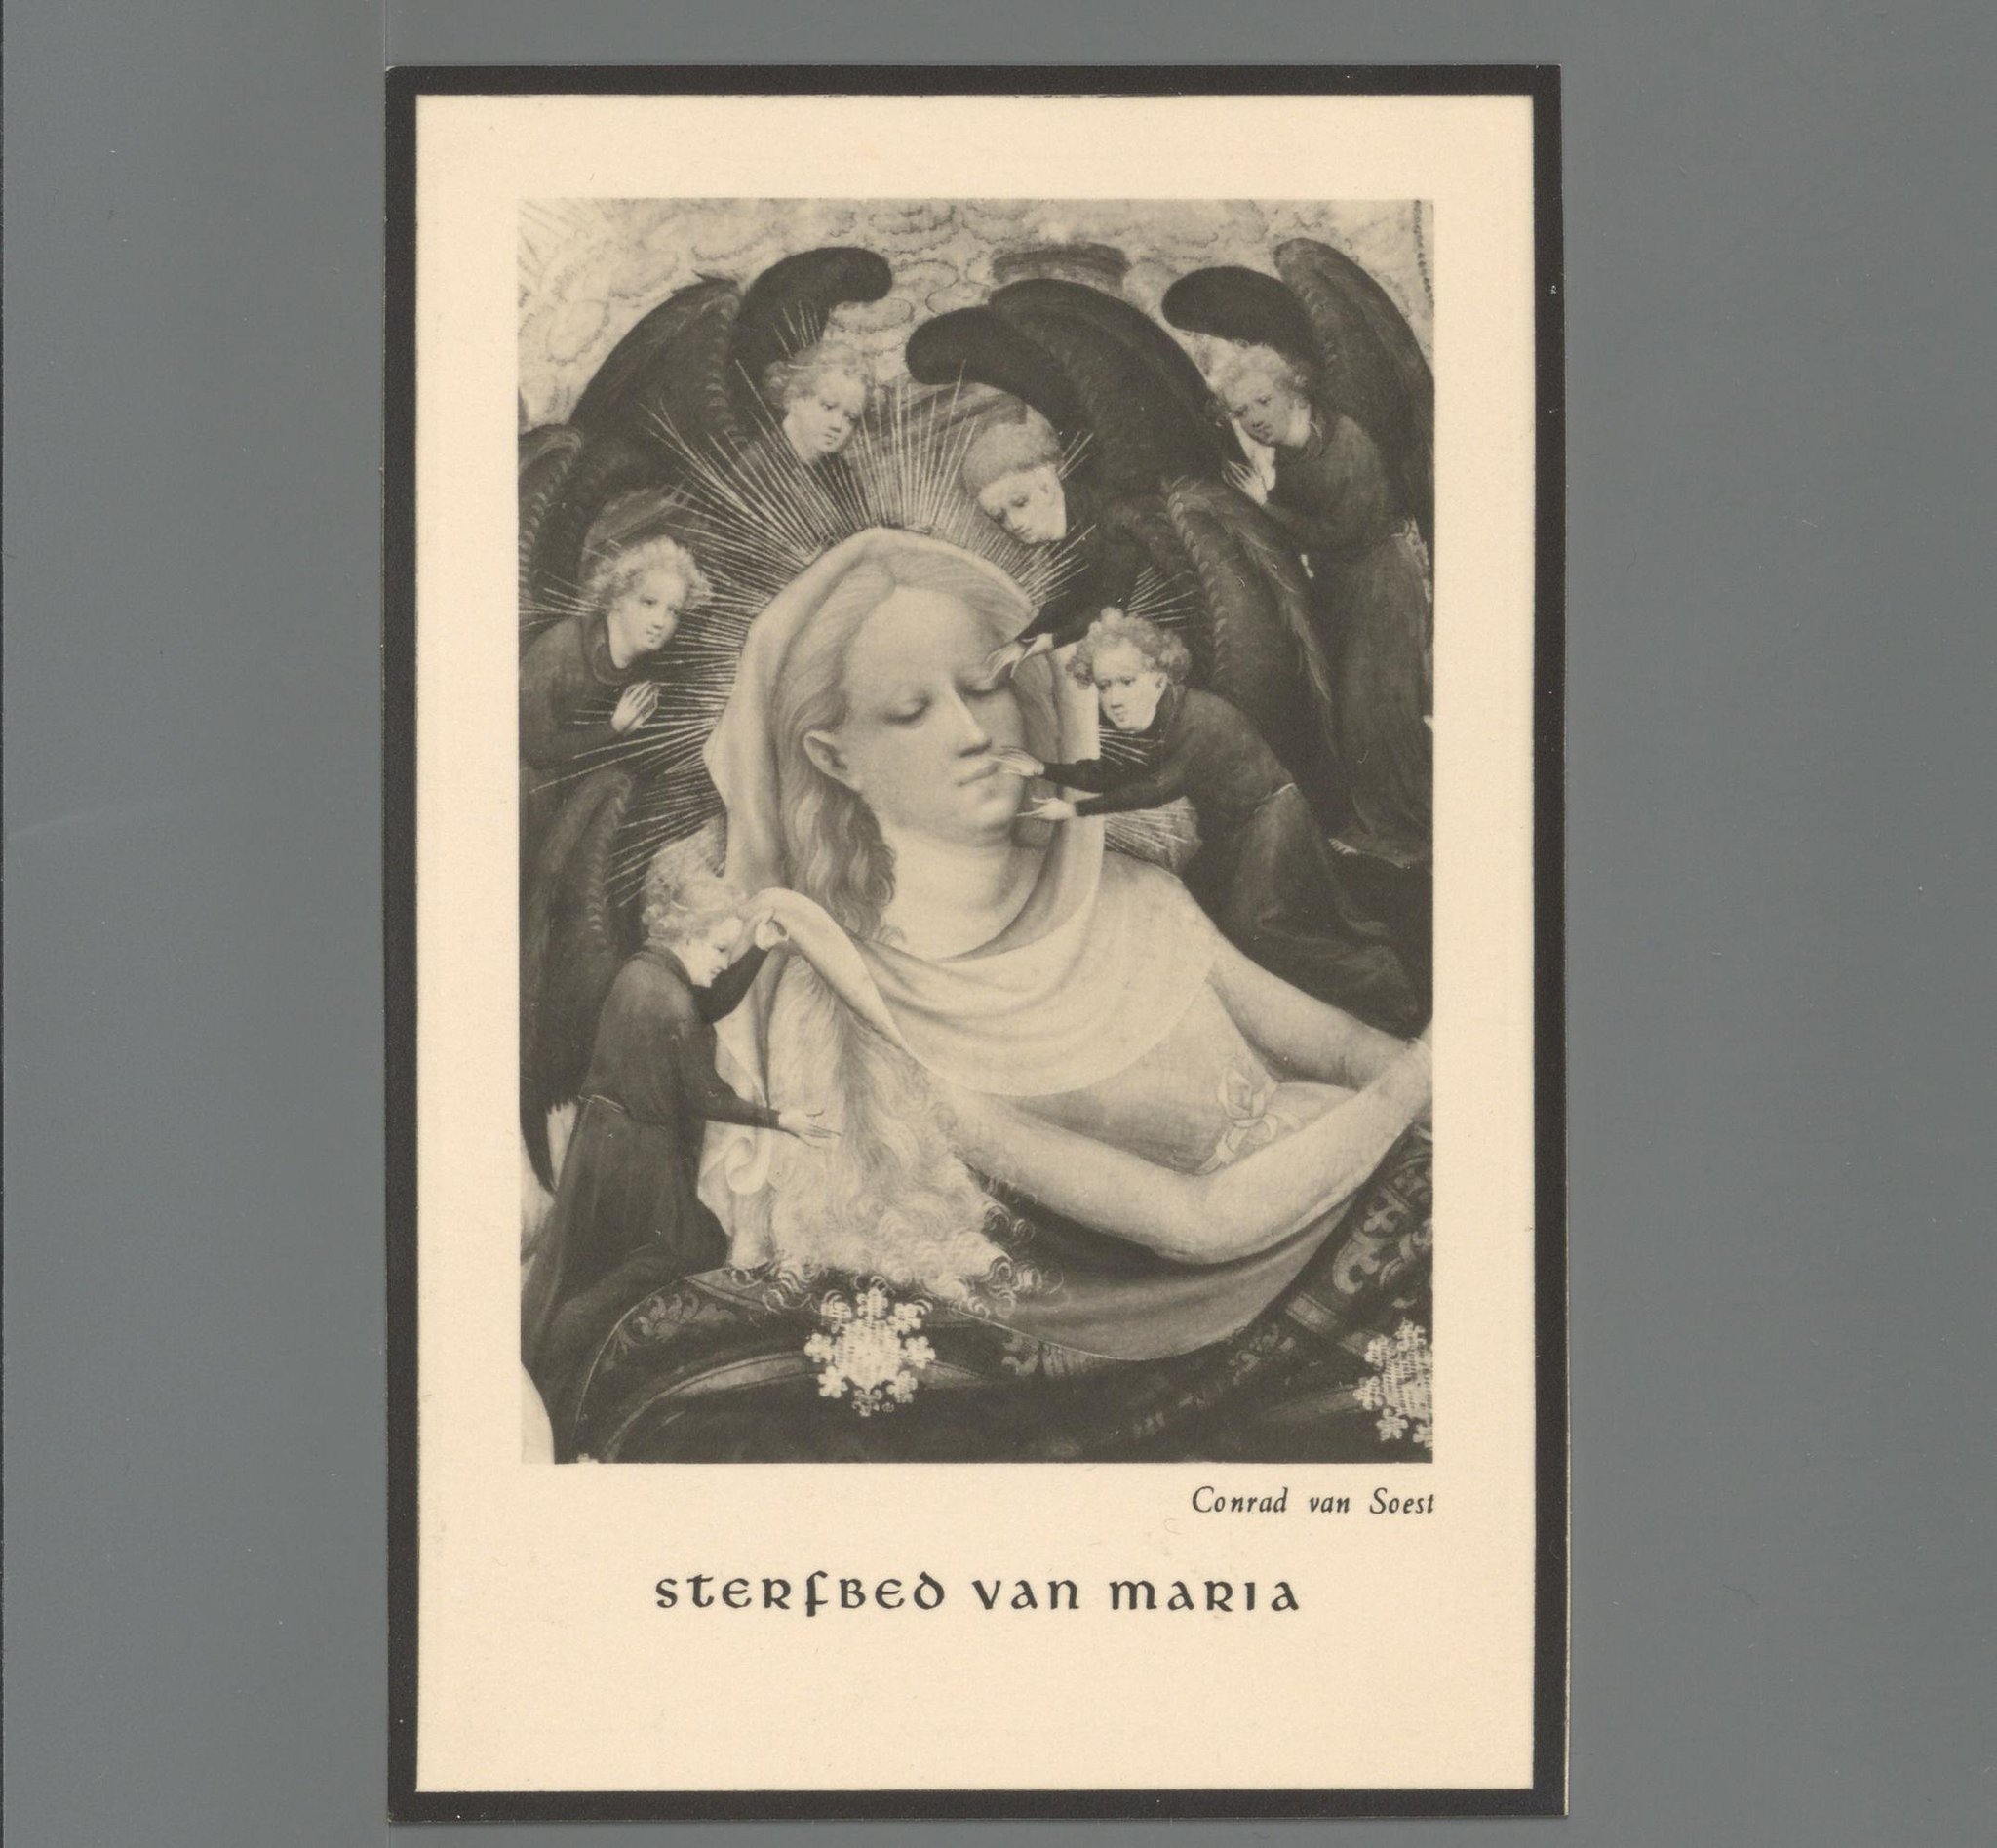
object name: photograph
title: Sterfbed van Maria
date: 1950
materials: cardboard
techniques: gelatin silver print, letterpress printing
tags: mary (without the christ-child), angels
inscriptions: date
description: Op recto de kunstreproductie, op verso de herdenkingstekst voor Anna Christina Geertruida van Thiel, overleden op 1 april 1950.